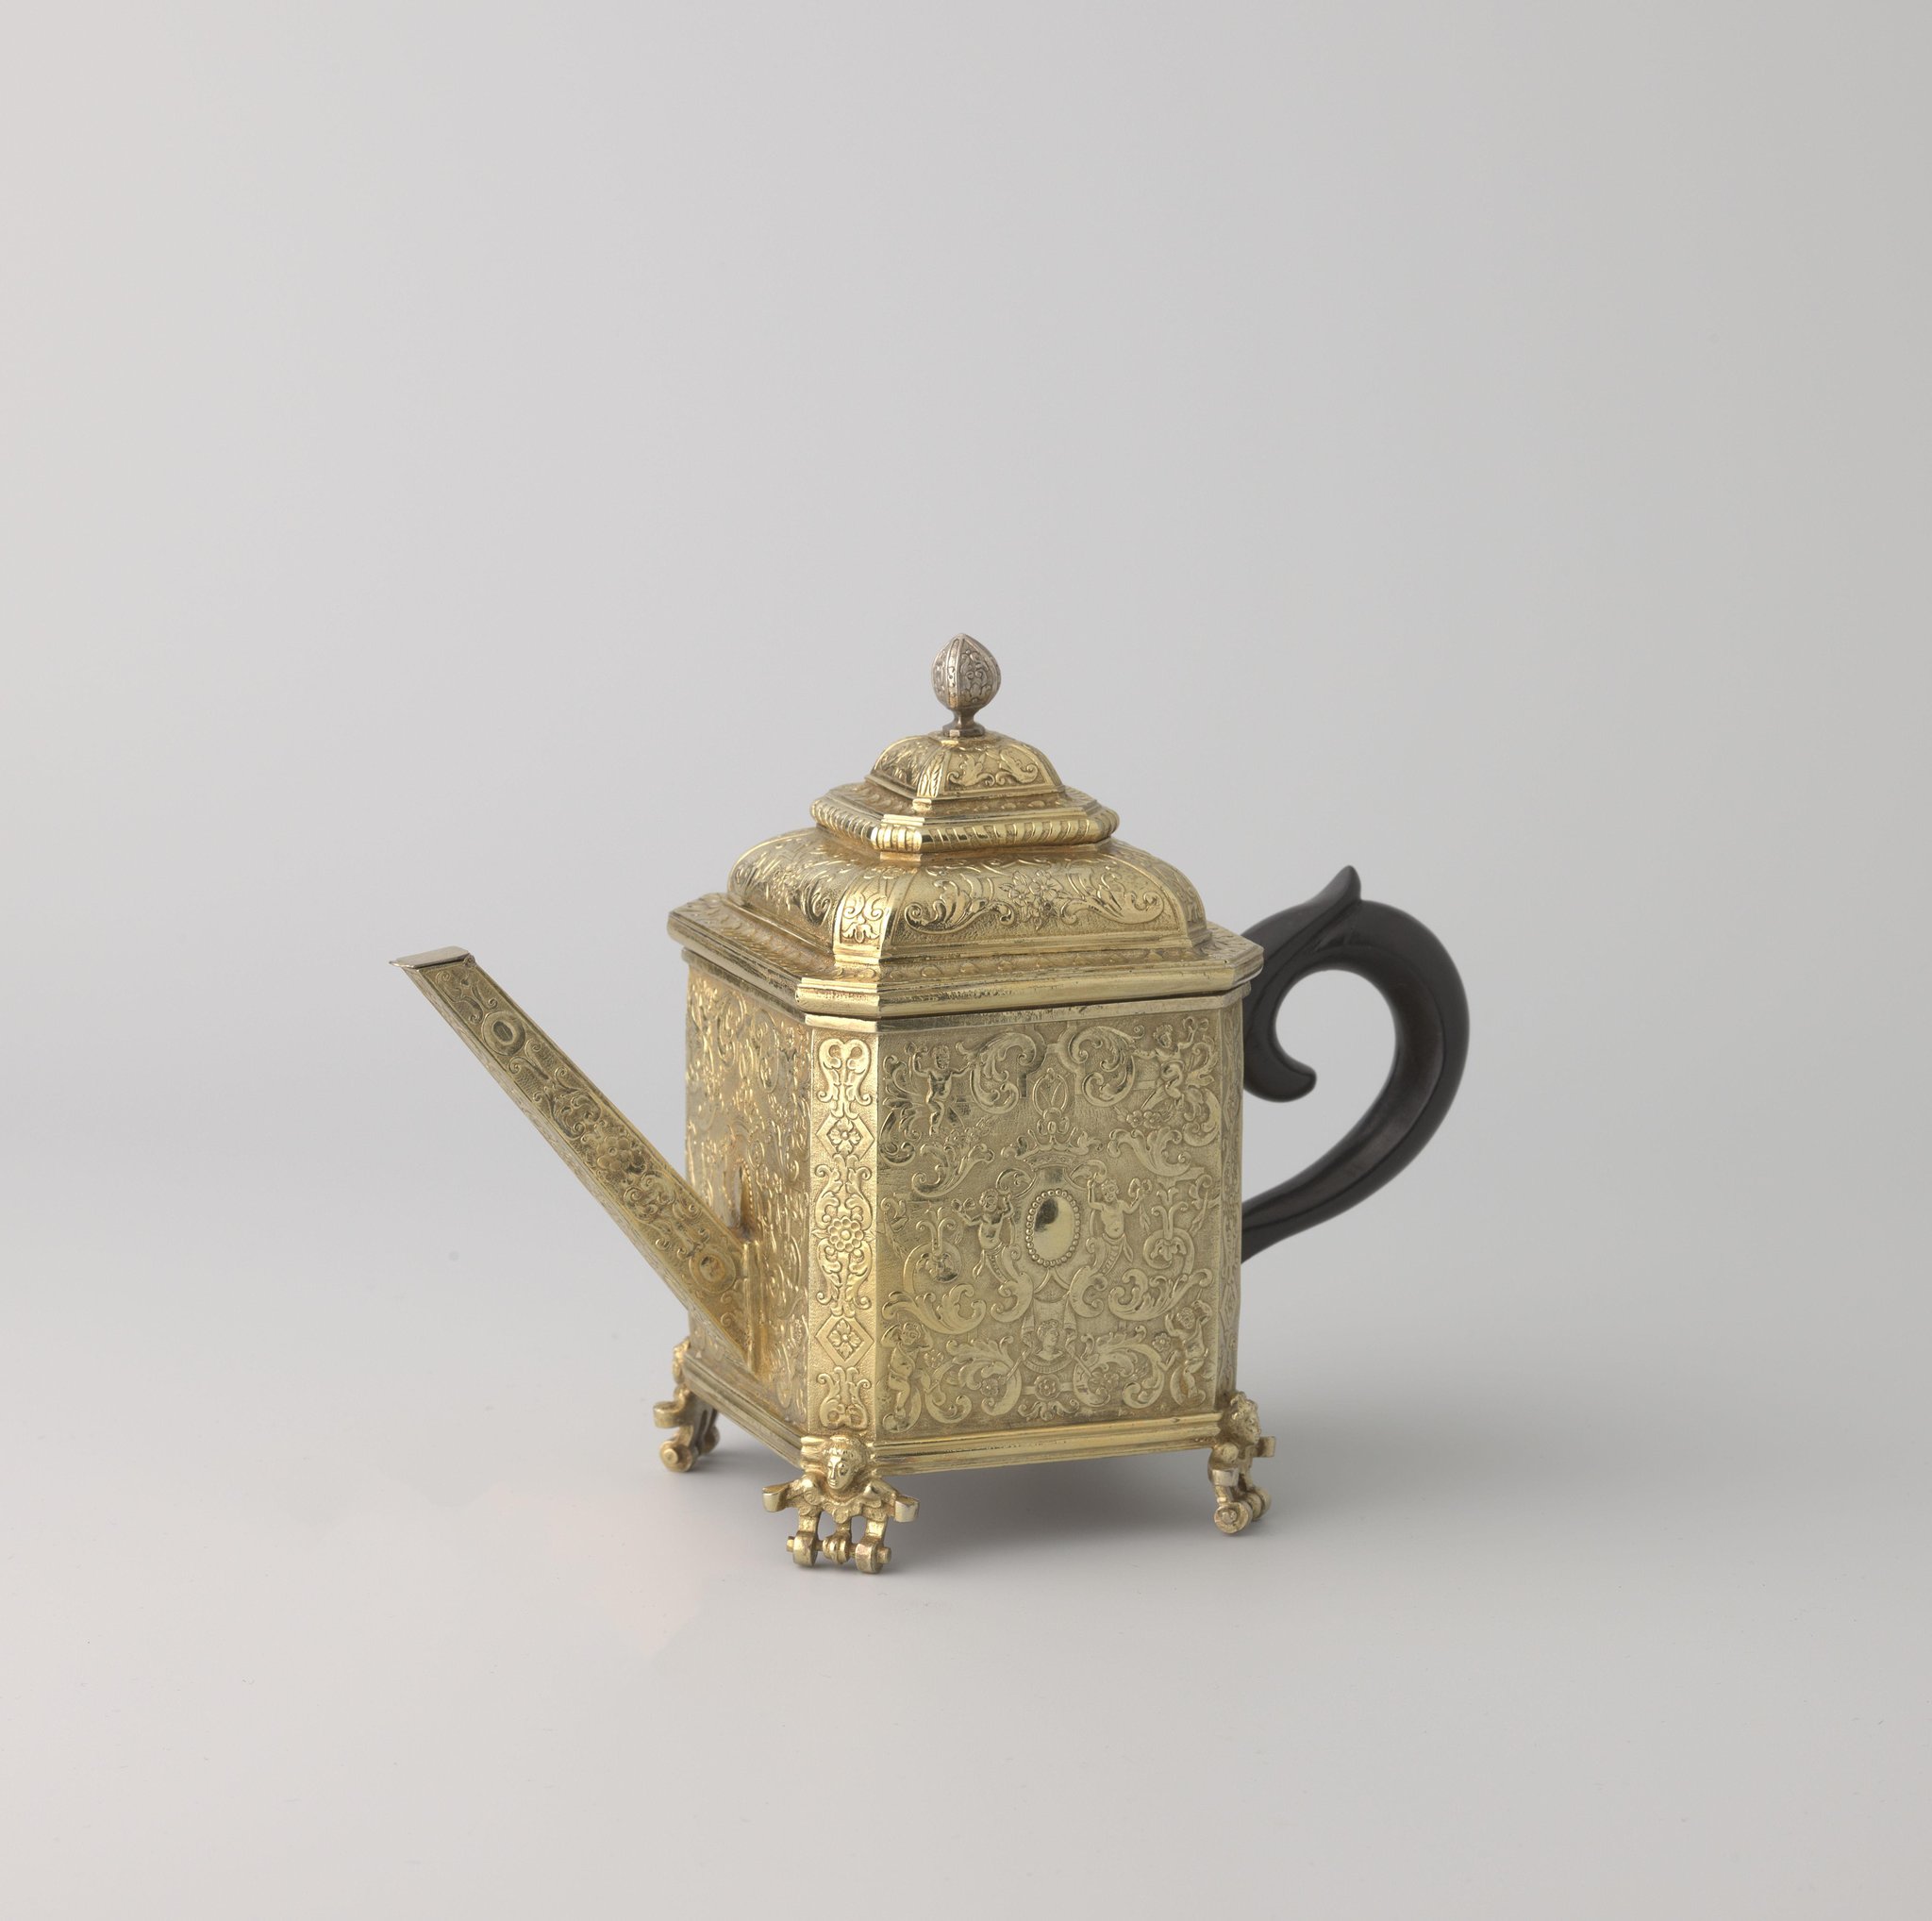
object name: teapot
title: Theepot, vierkant met afgeschuinde hoeken, met decoratie in Lodewijk XIV-stijl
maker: Anonymous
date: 1880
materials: silver, wood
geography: hanau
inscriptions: maker's mark: ‘PA’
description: Teapot. Silver gilt, Leeuwarden (?), c. 1700, maker's mark and monogram P and A.